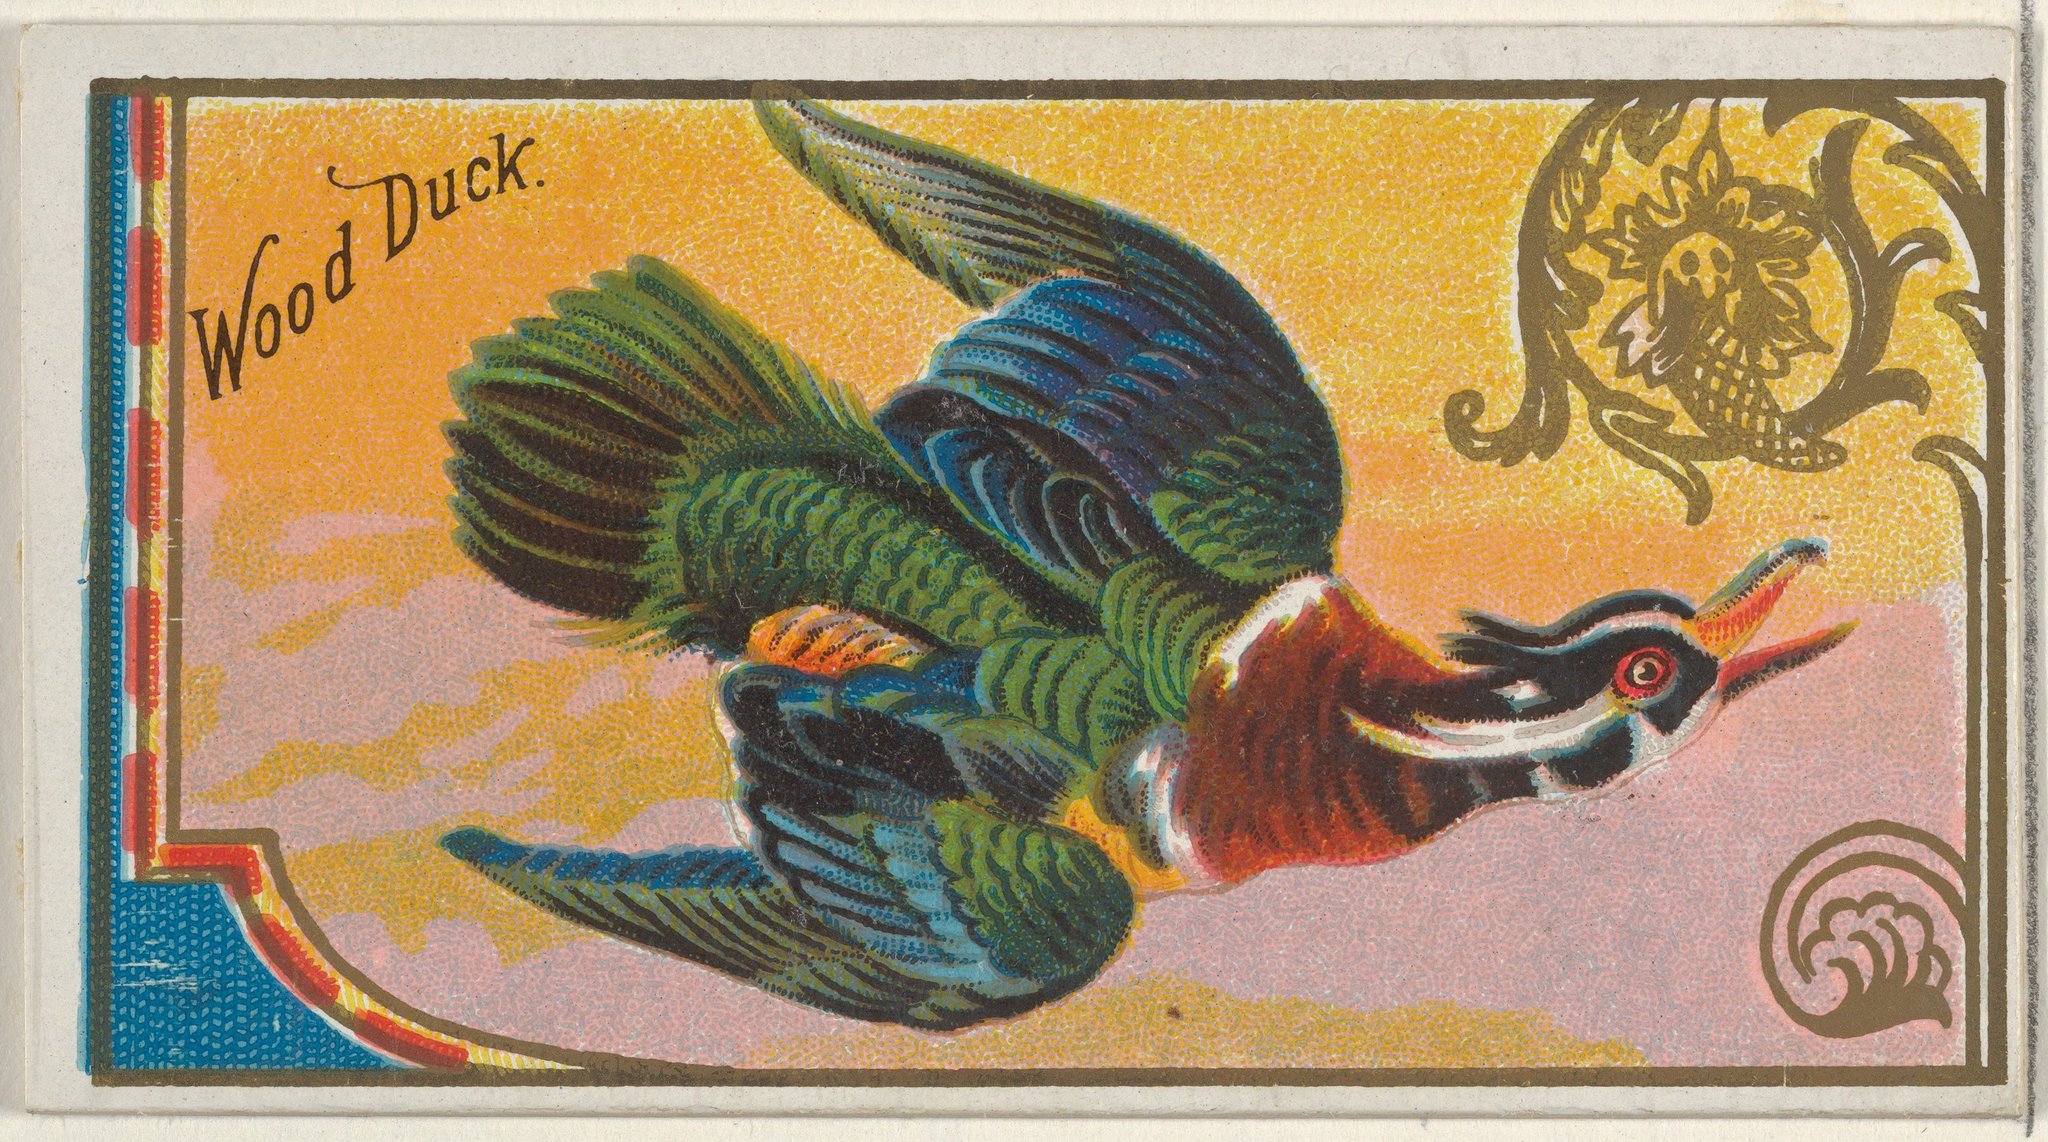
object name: print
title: Wood Duck, from the Game Birds series (N13) for Allen & Ginter Cigarettes Brands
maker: allen & ginter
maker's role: publisher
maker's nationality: american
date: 1889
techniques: color lithograph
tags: ducks